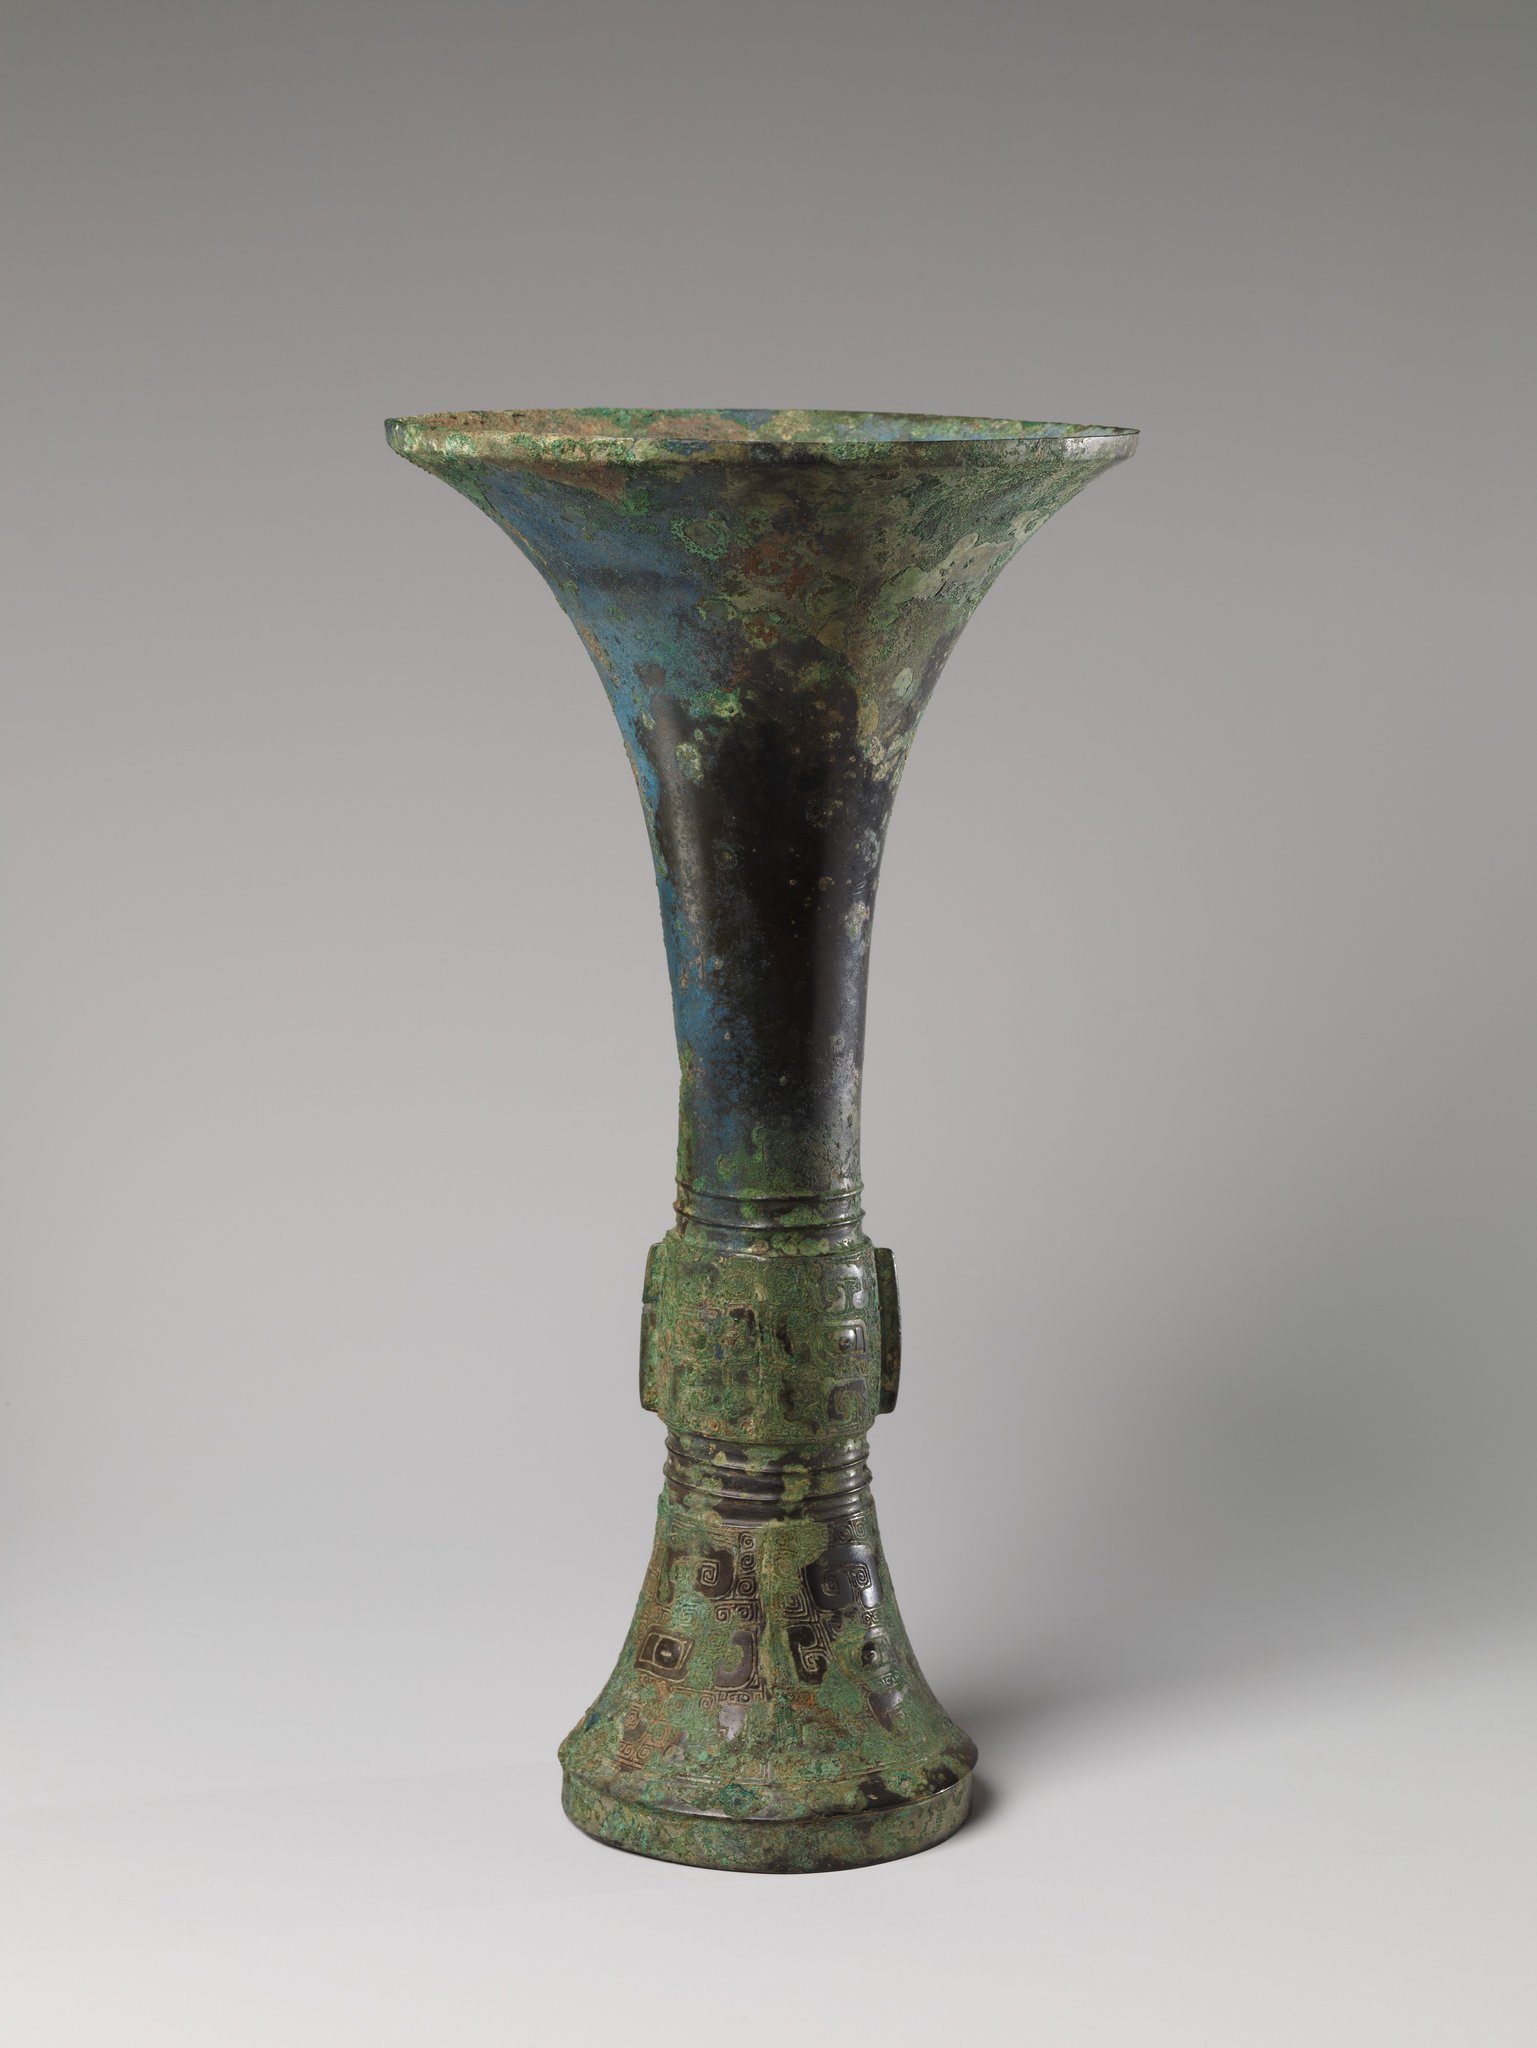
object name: wine beaker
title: Wine beaker (gu)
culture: chinese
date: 1300-1001 BCE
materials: bronze